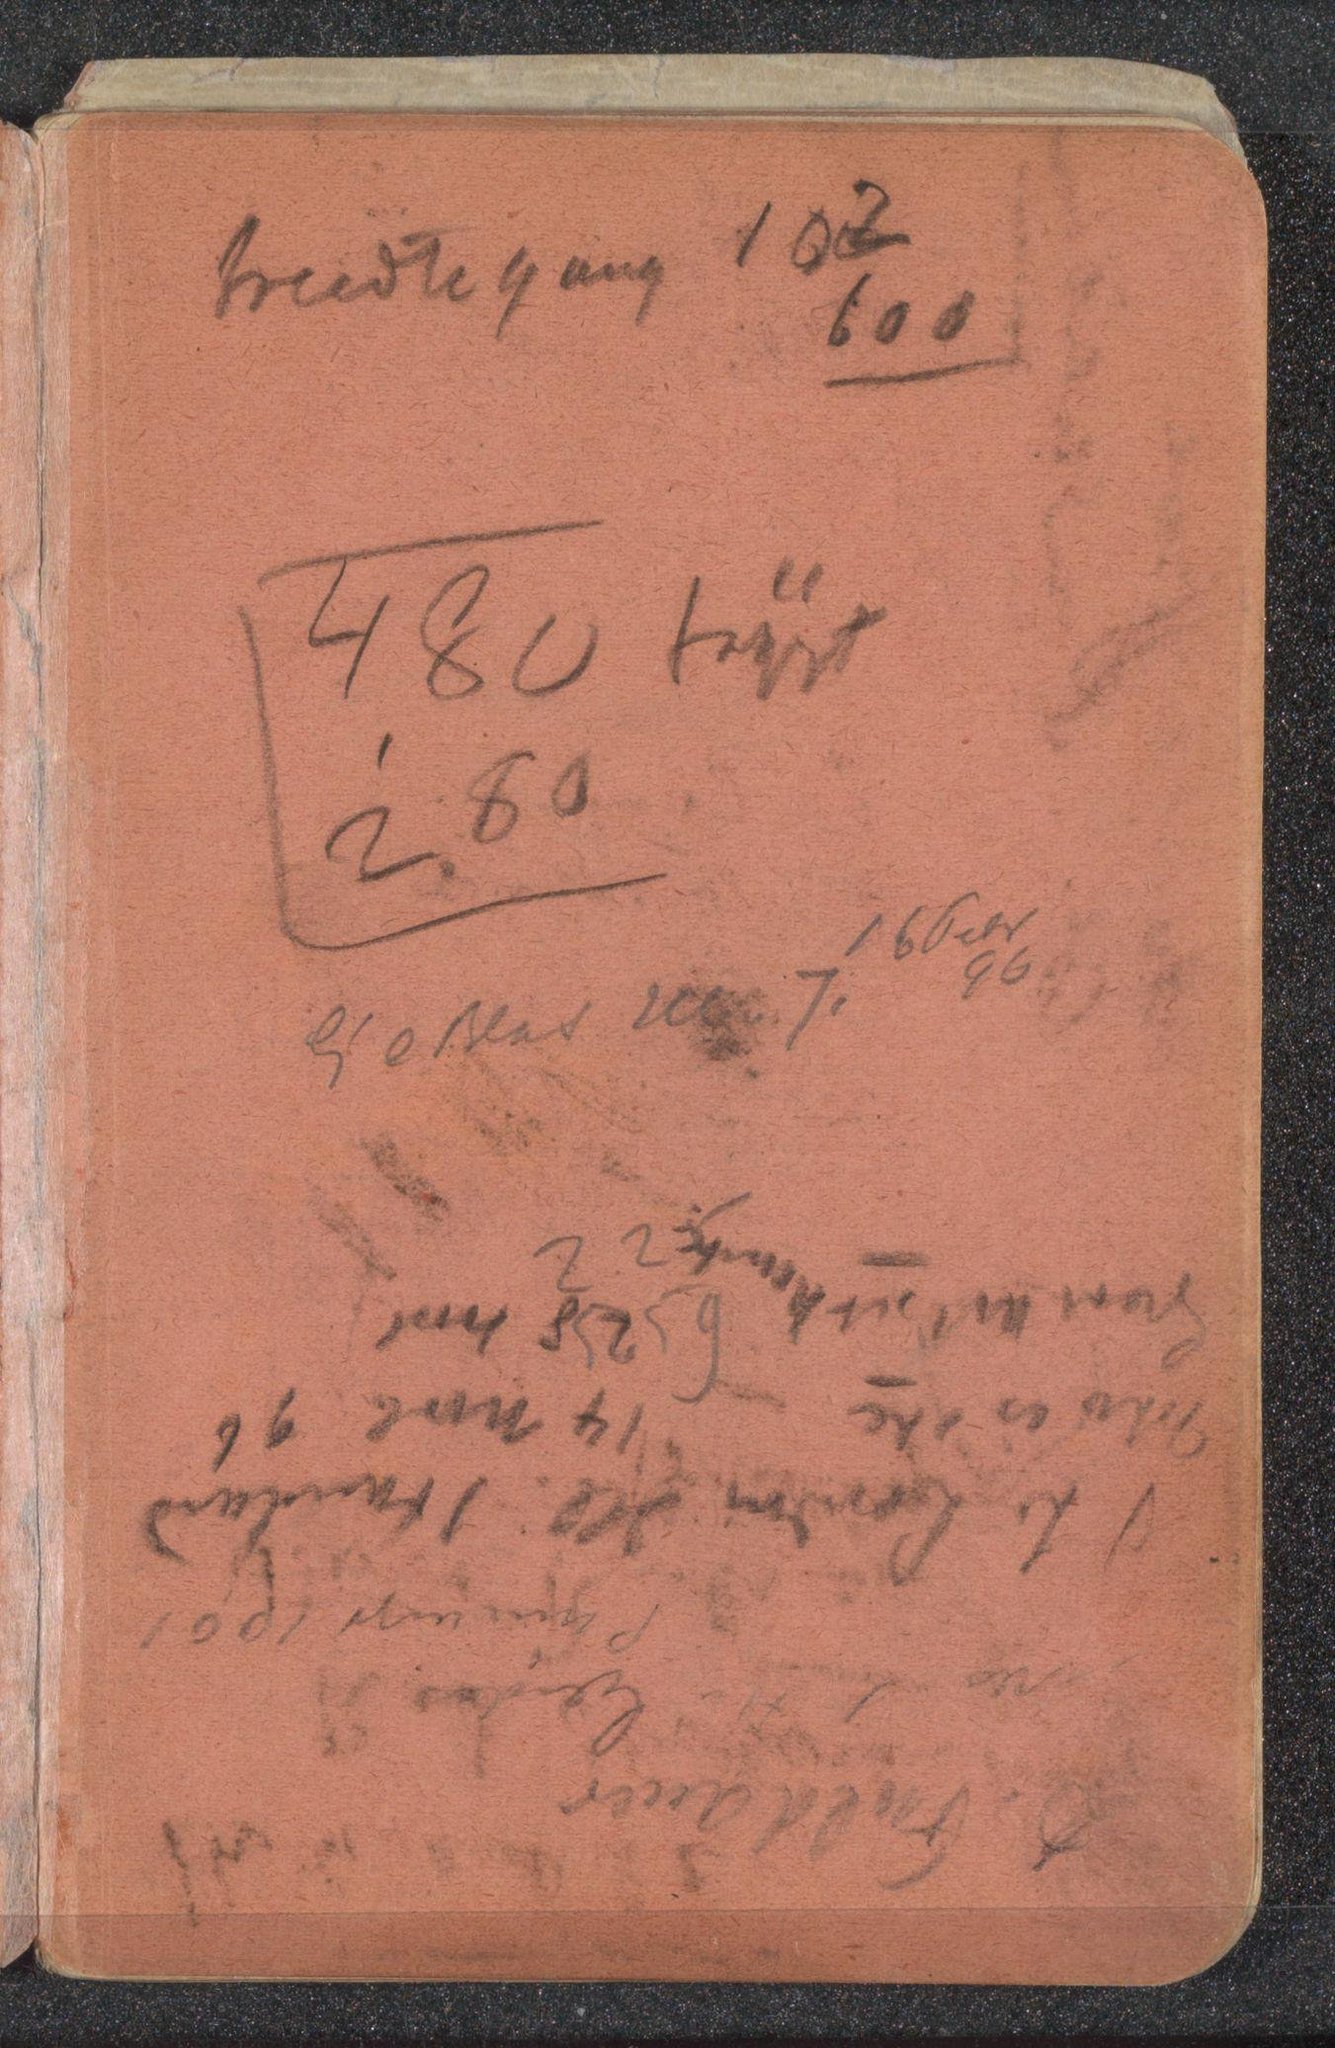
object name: endleaf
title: Annotaties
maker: george hendrik breitner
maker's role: draughtsman, painter, print maker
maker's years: 1857-1923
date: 1896-1901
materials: chalk, paper, pencil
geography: amsterdam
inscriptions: annotation: ‘[...]’, size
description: Vrij schutblad uit een schetsboek met 37 bladen.